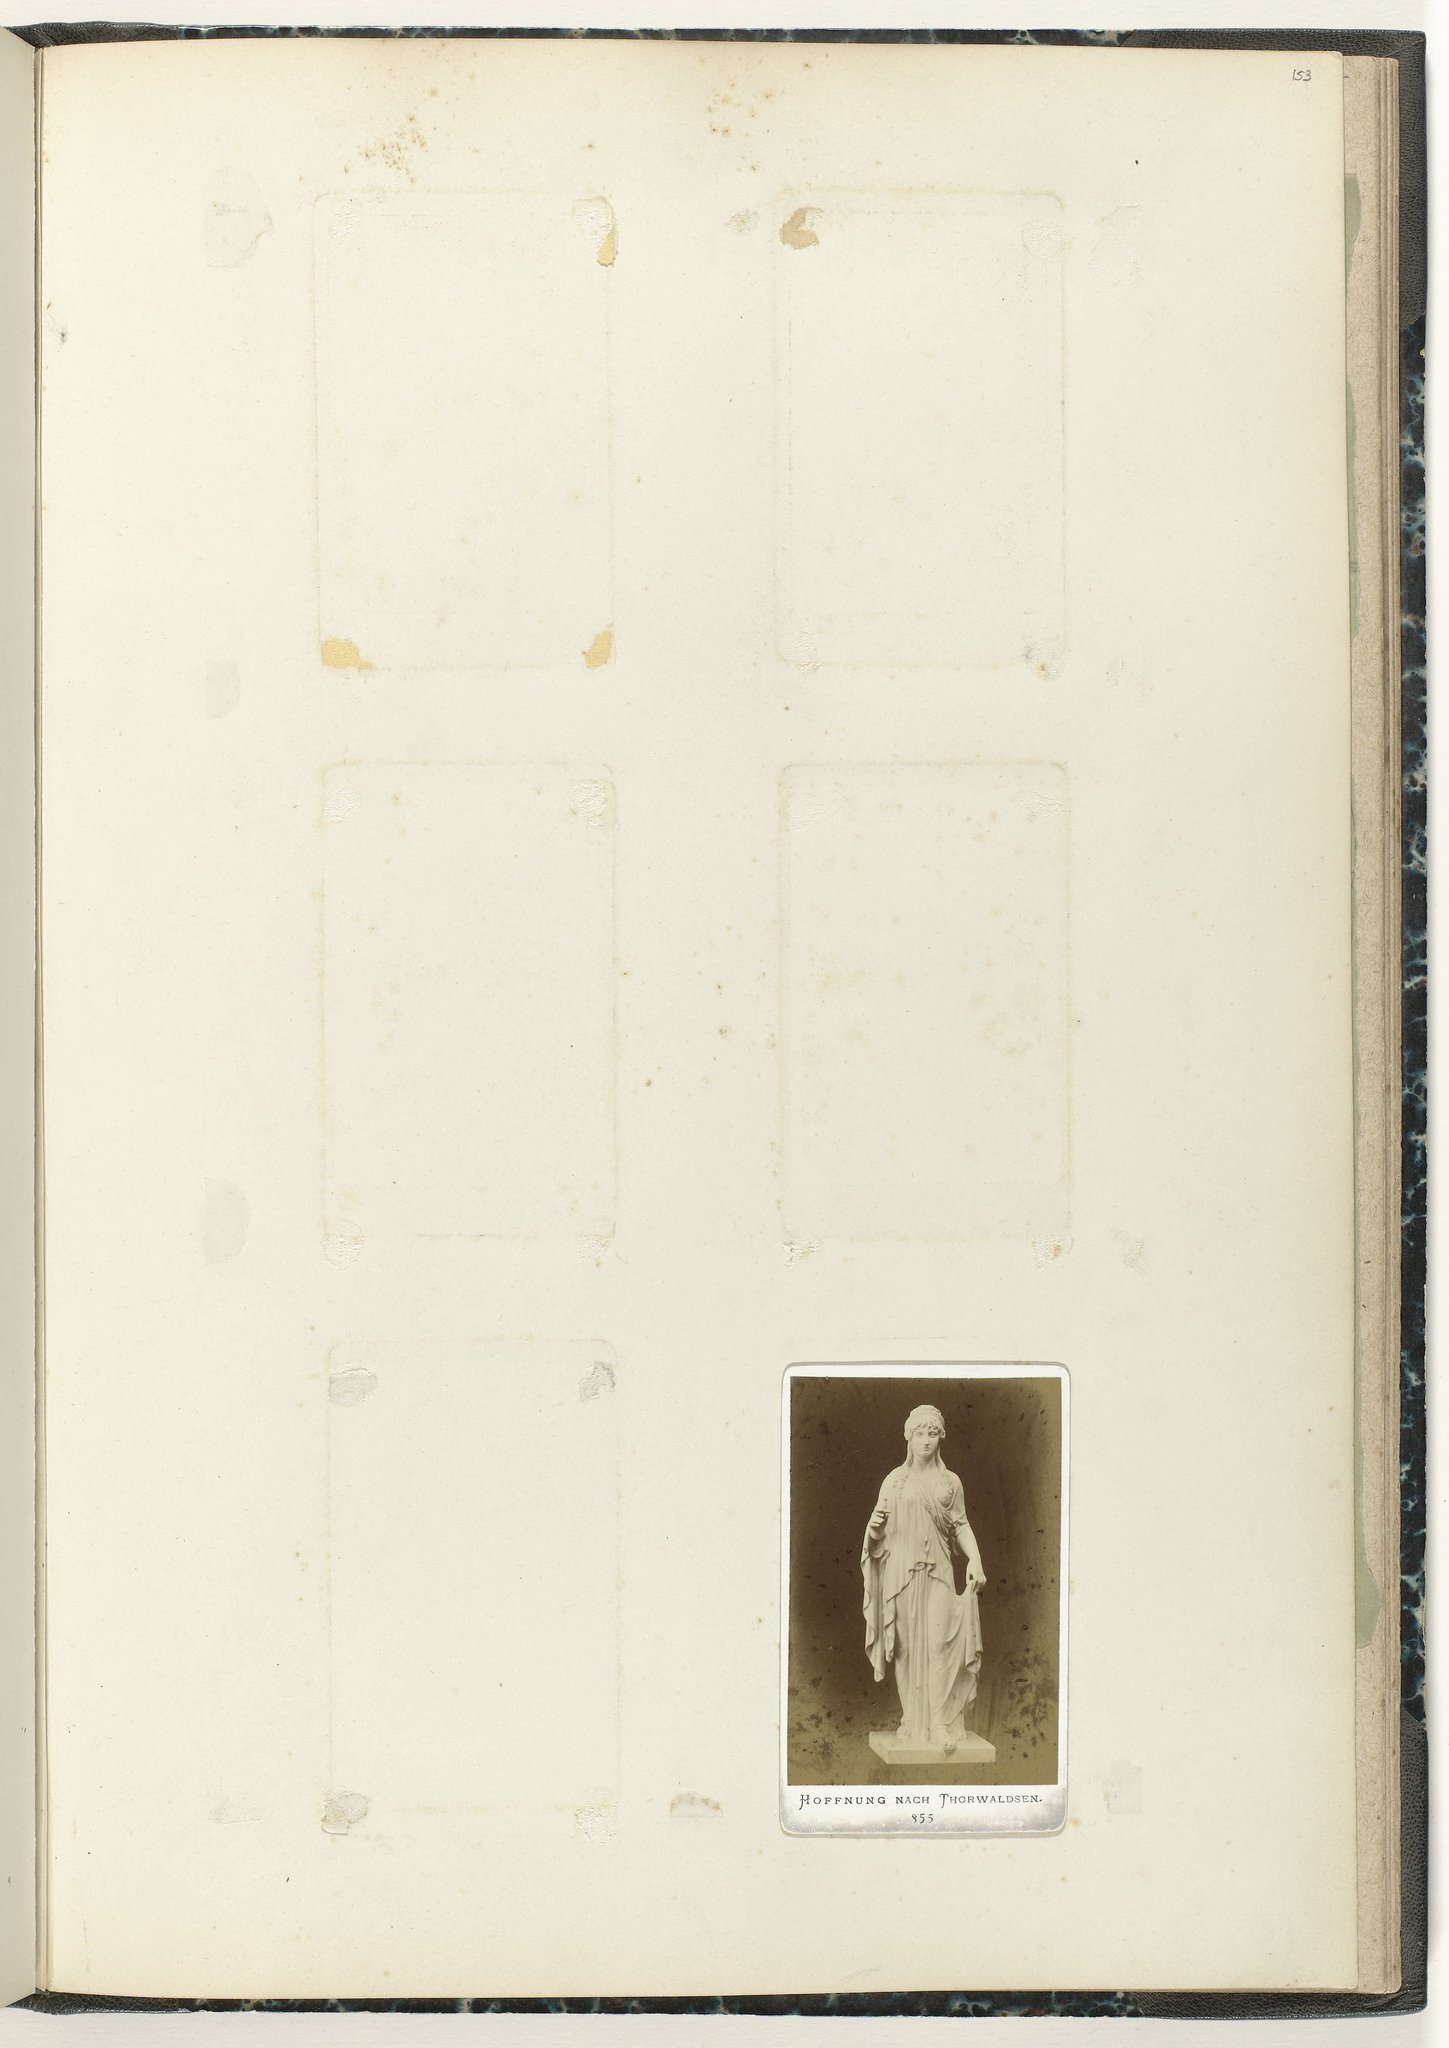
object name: photograph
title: Carte-de-visite met beeld van Hoop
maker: Anonymous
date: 1866-1900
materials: cardboard, paper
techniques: albumen print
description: Hoop naar Thorwaldsen, onderaan staat het getal 355 gedrukt.